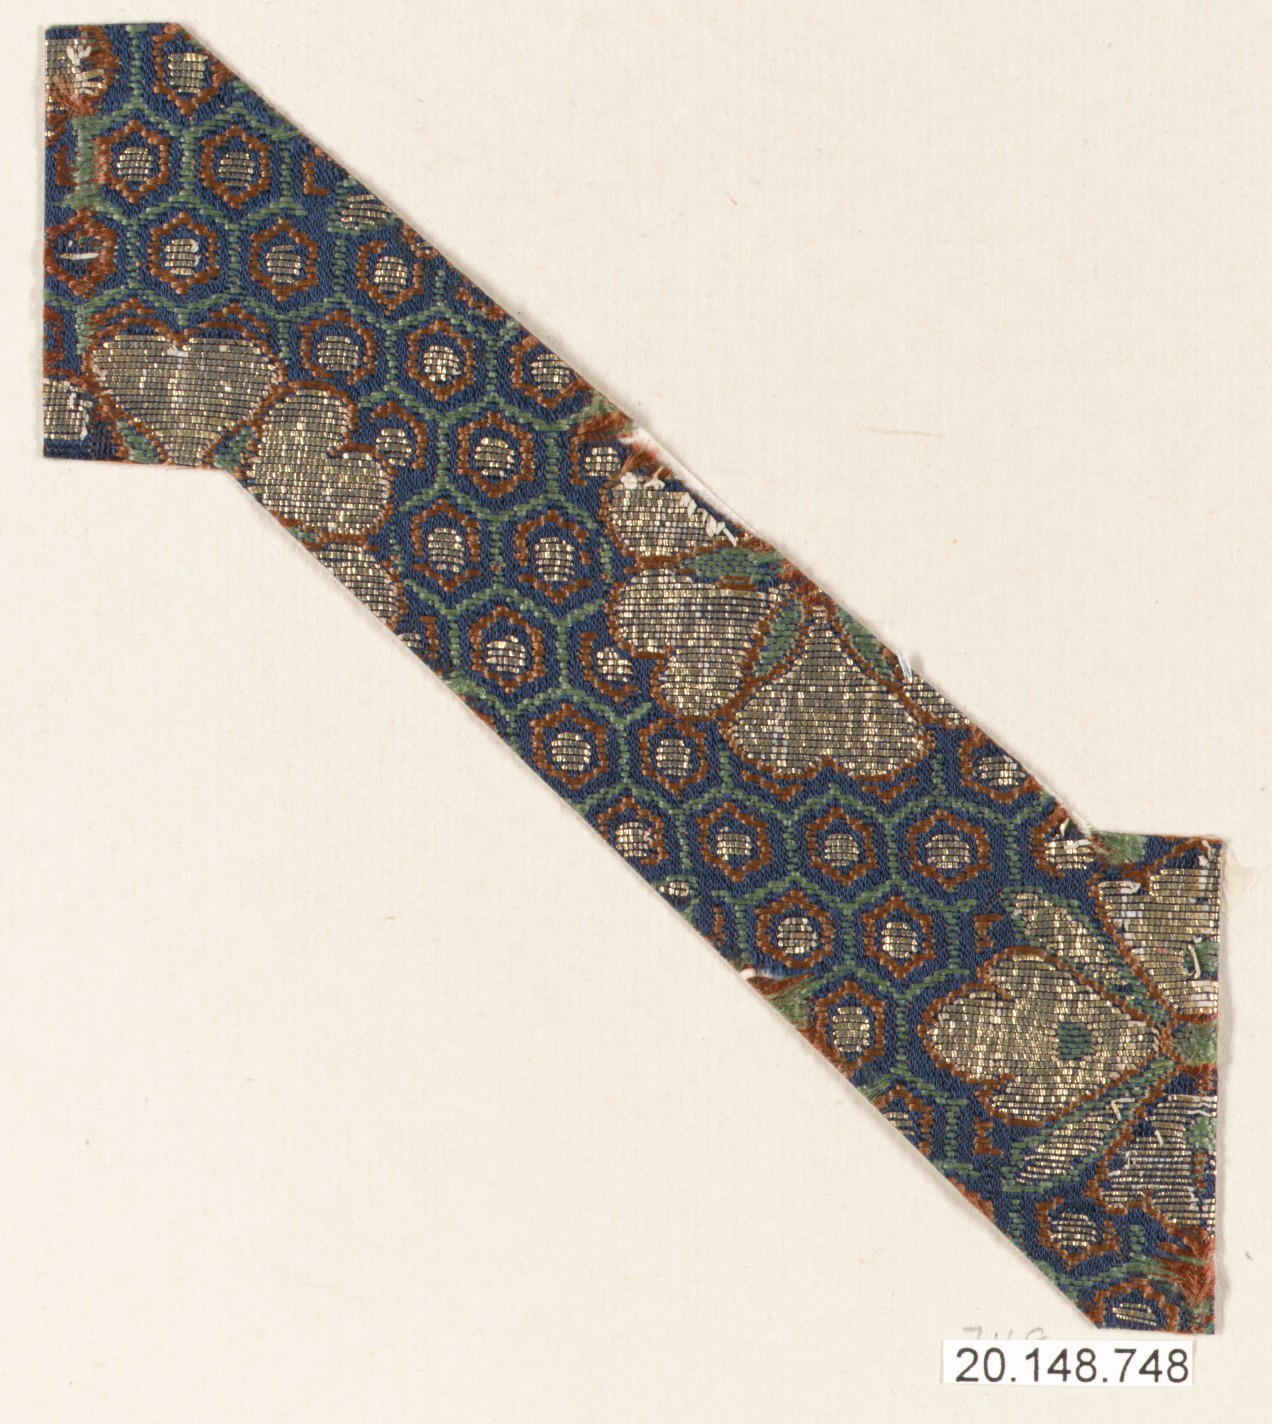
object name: piece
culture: chinese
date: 1368-1644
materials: silk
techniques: compound weave